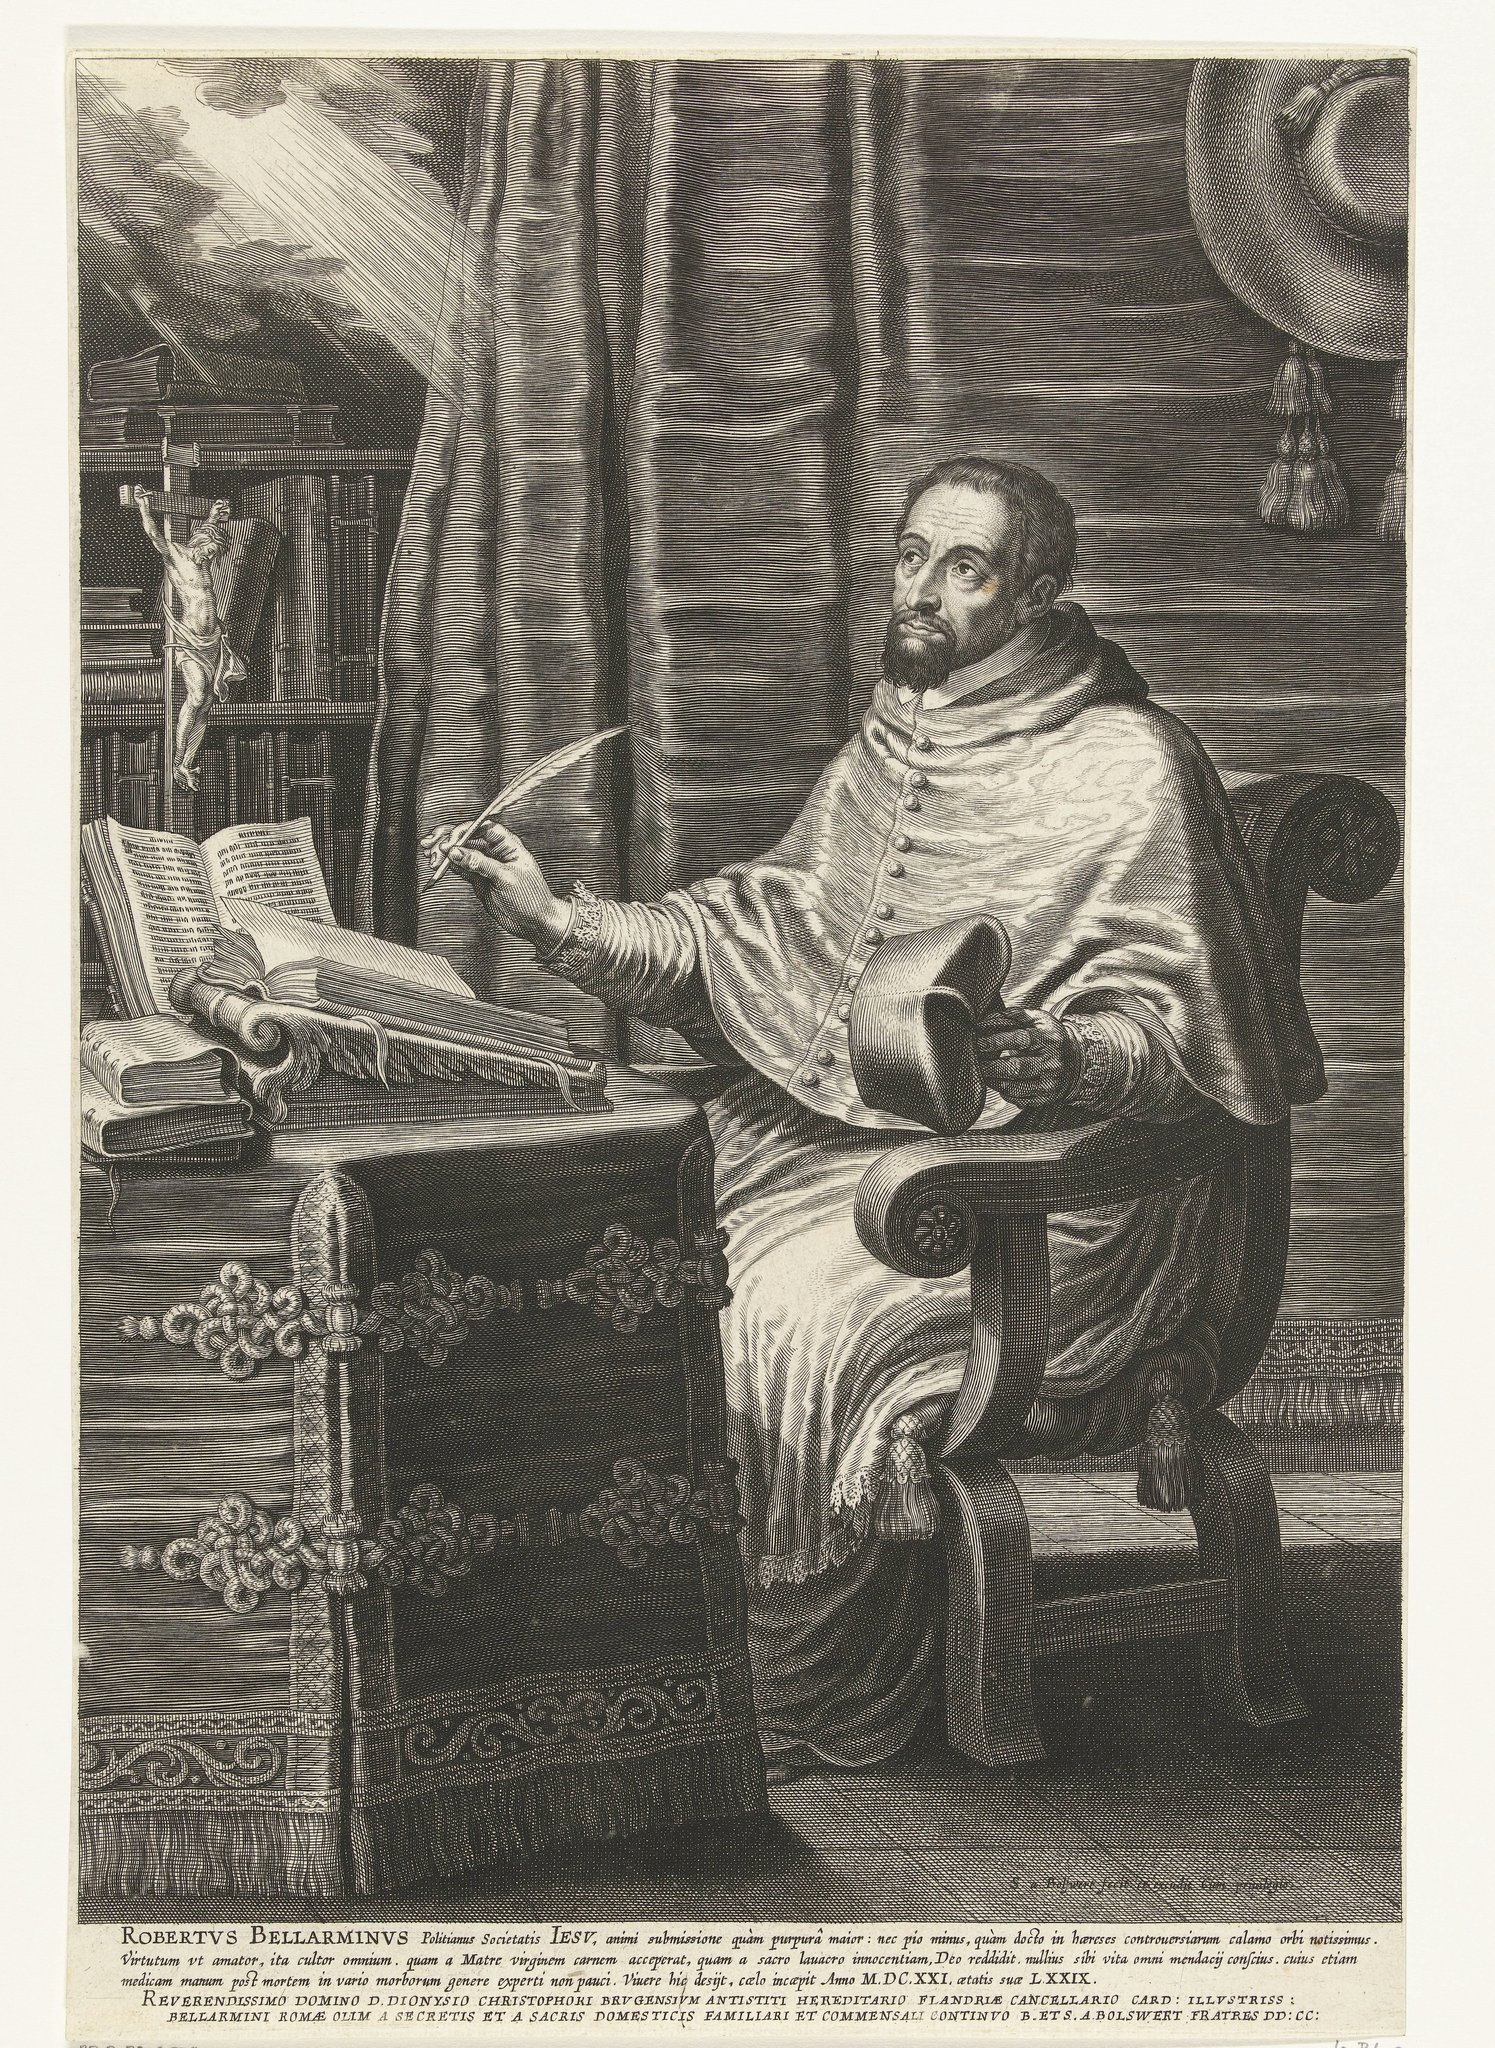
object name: print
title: Heilige kardinaal Robertus Bellarminus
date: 1596-1659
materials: paper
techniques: engraving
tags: rome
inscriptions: collector's mark: Lugt 240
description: De heilige kardinaal Robertus Bellarminus zit in een studeervertrek en werkt aan zijn geschriften. Zijn blik is gericht op een crucifix op de tafel voor hem en uit de hemel schijnt een bundel lichtstralen, zijn goddelijke inspiratie.